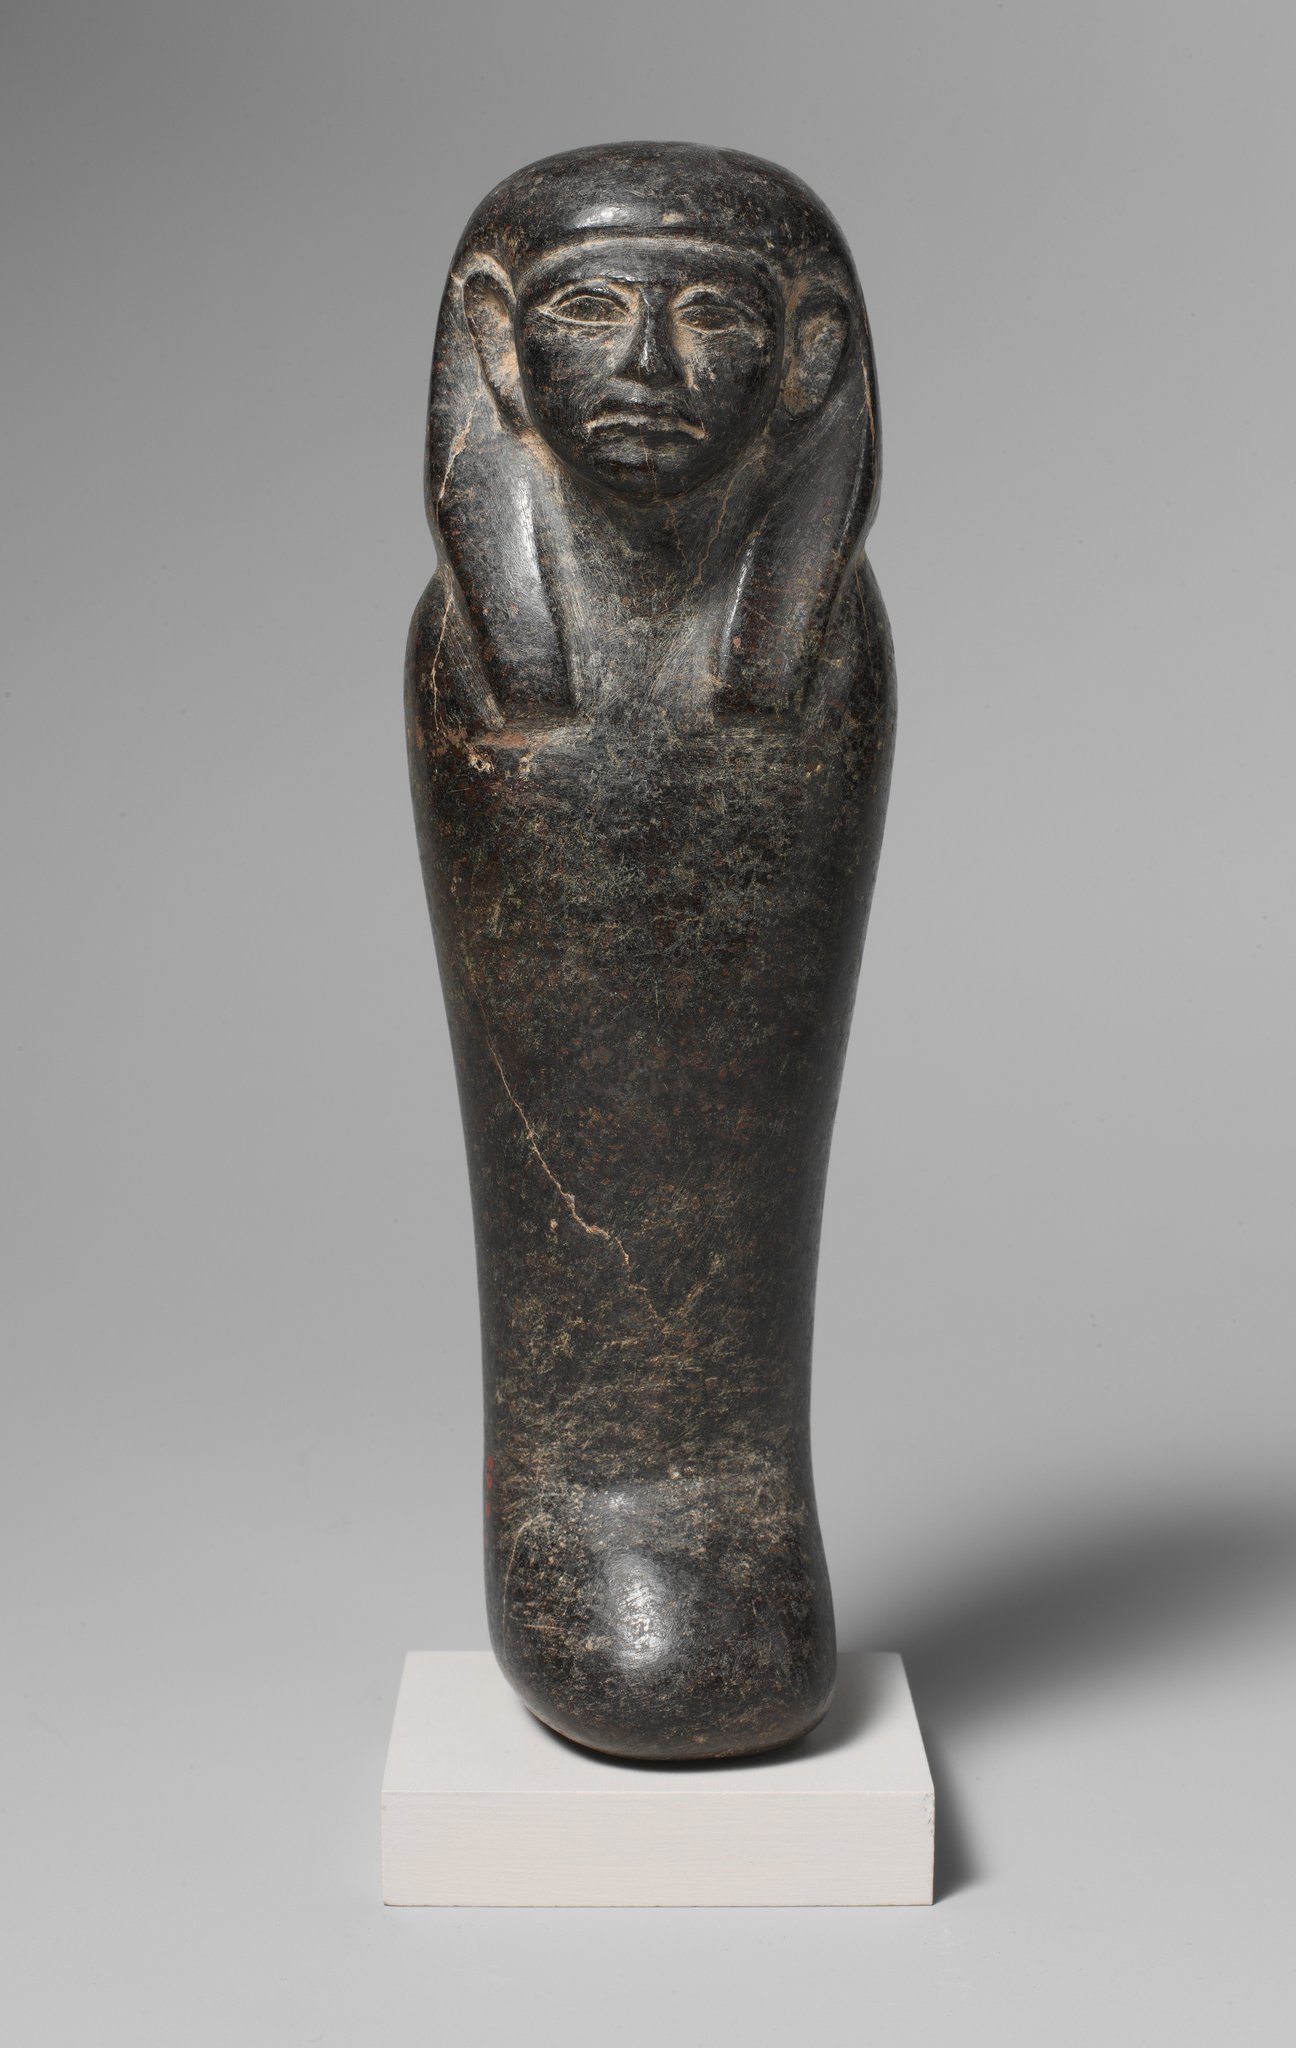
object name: shabti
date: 1981-1550 BCE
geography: egypt